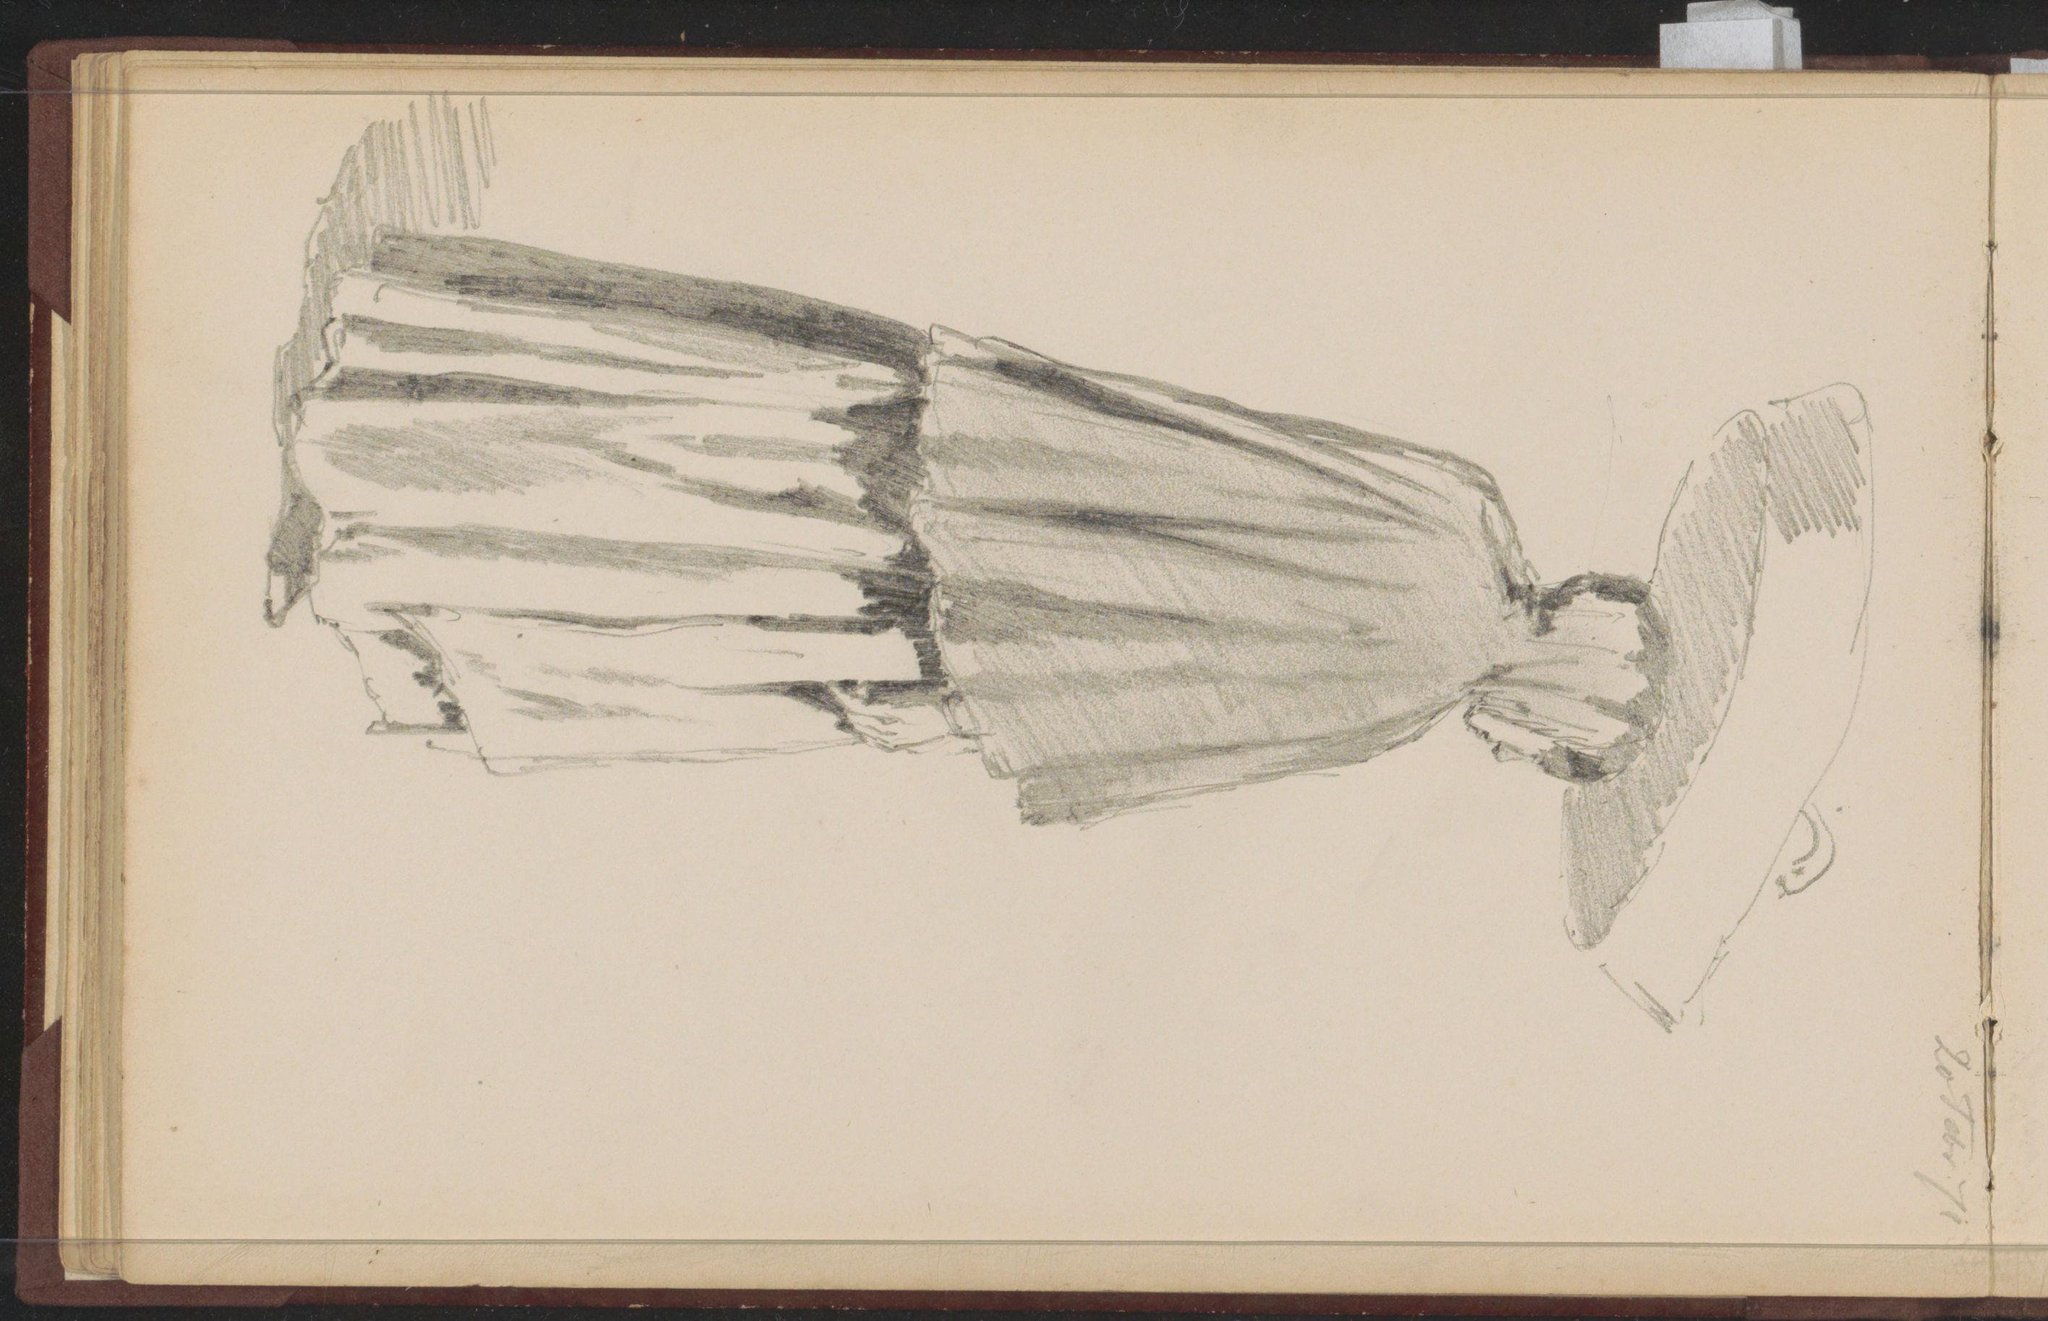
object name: sketchbook leaf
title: Vrouw met een mand op het hoofd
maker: cornelis springer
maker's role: draughtsman, painter, print maker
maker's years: 1817-1891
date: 1871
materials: paper, pencil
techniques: stumping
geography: netherlands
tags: adult woman, carrying something in basket, bag, rucksack, etc.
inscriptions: date: ‘20 Febr 71’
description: Vrouw met een mand op het hoofd. Blad 13 verso uit een schetsboek met 39 bladen, deels vervaardigd te Ulm en Leiden.